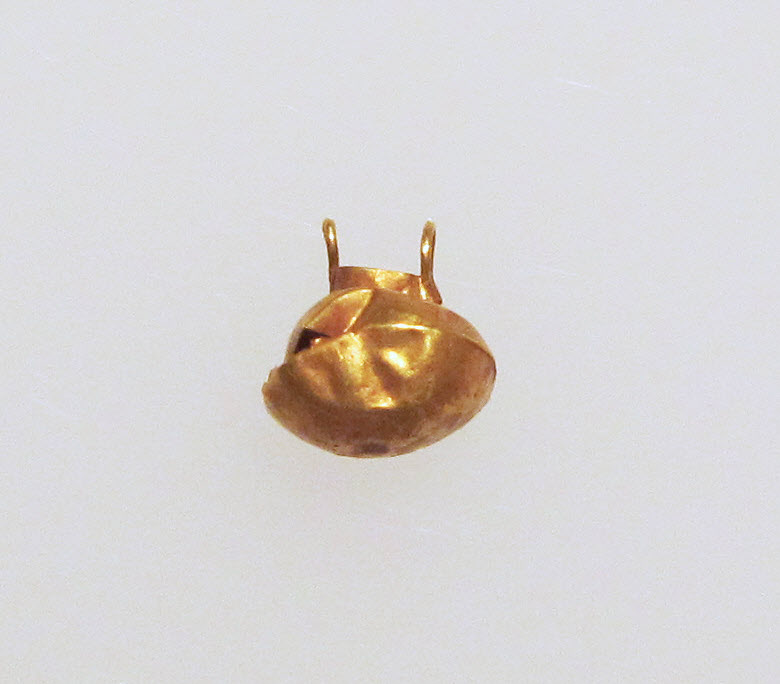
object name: pendant in the form of a vase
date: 7000 BCE-330 CE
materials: gold